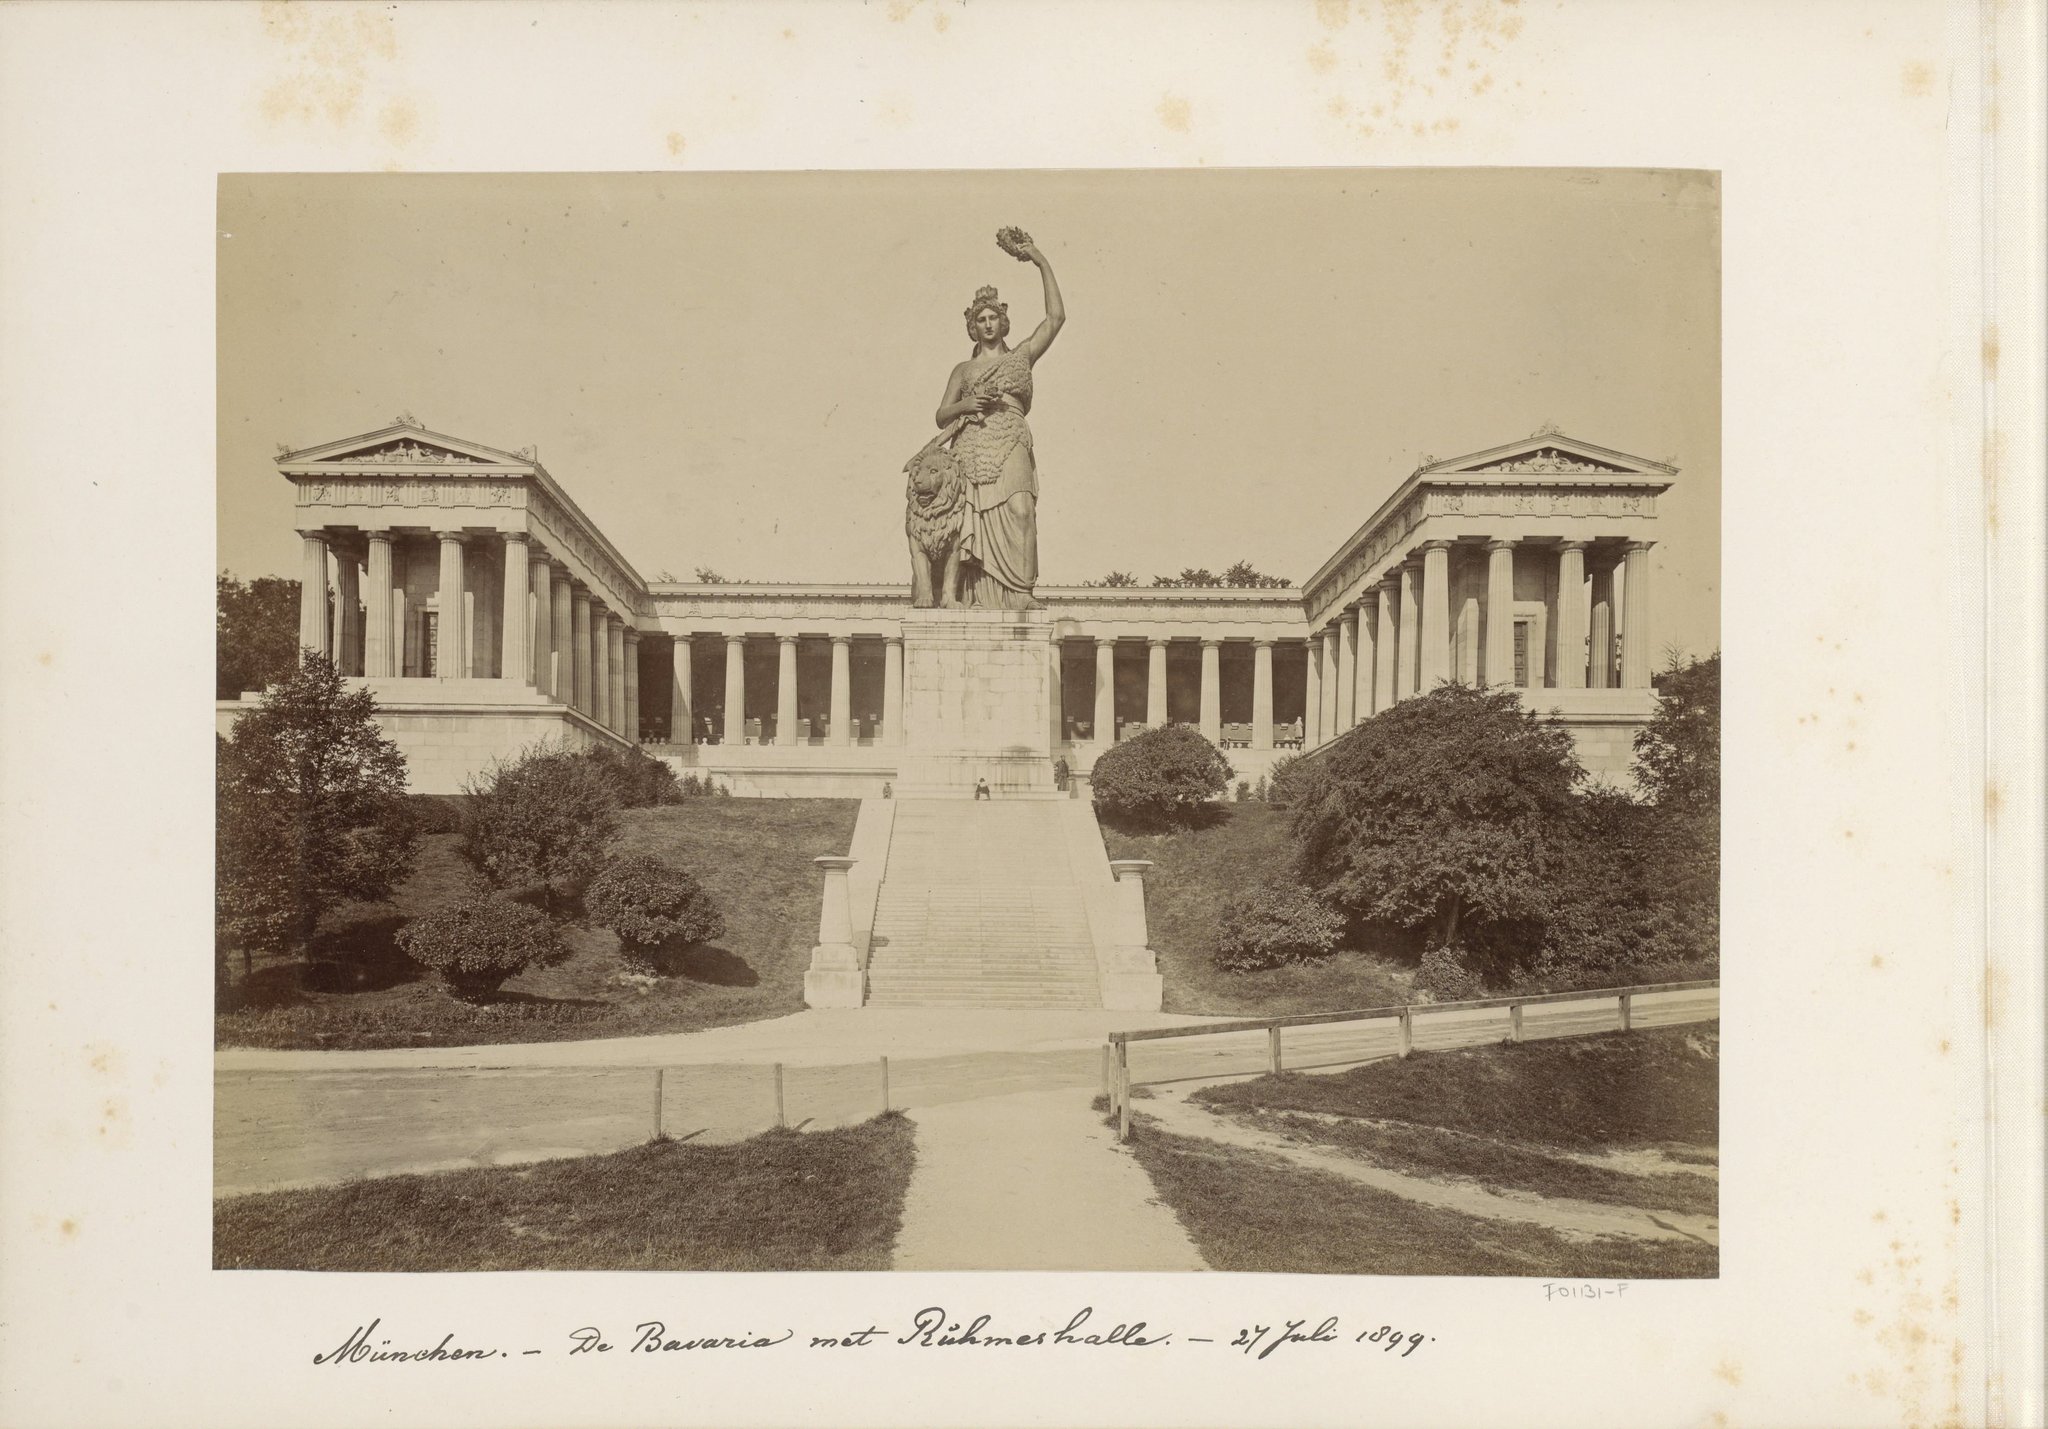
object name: photograph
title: Ruhmeshalle met het standbeeld van Bavaria in München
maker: Anonymous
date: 1880-1899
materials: paper, photographic support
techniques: albumen print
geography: munich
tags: colonnade, monument, statue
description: Onderdeel van Reisalbum met bezienswaardigheden in Duitsland, Oostenrijk, Zwitserland, Luxemburg en België.